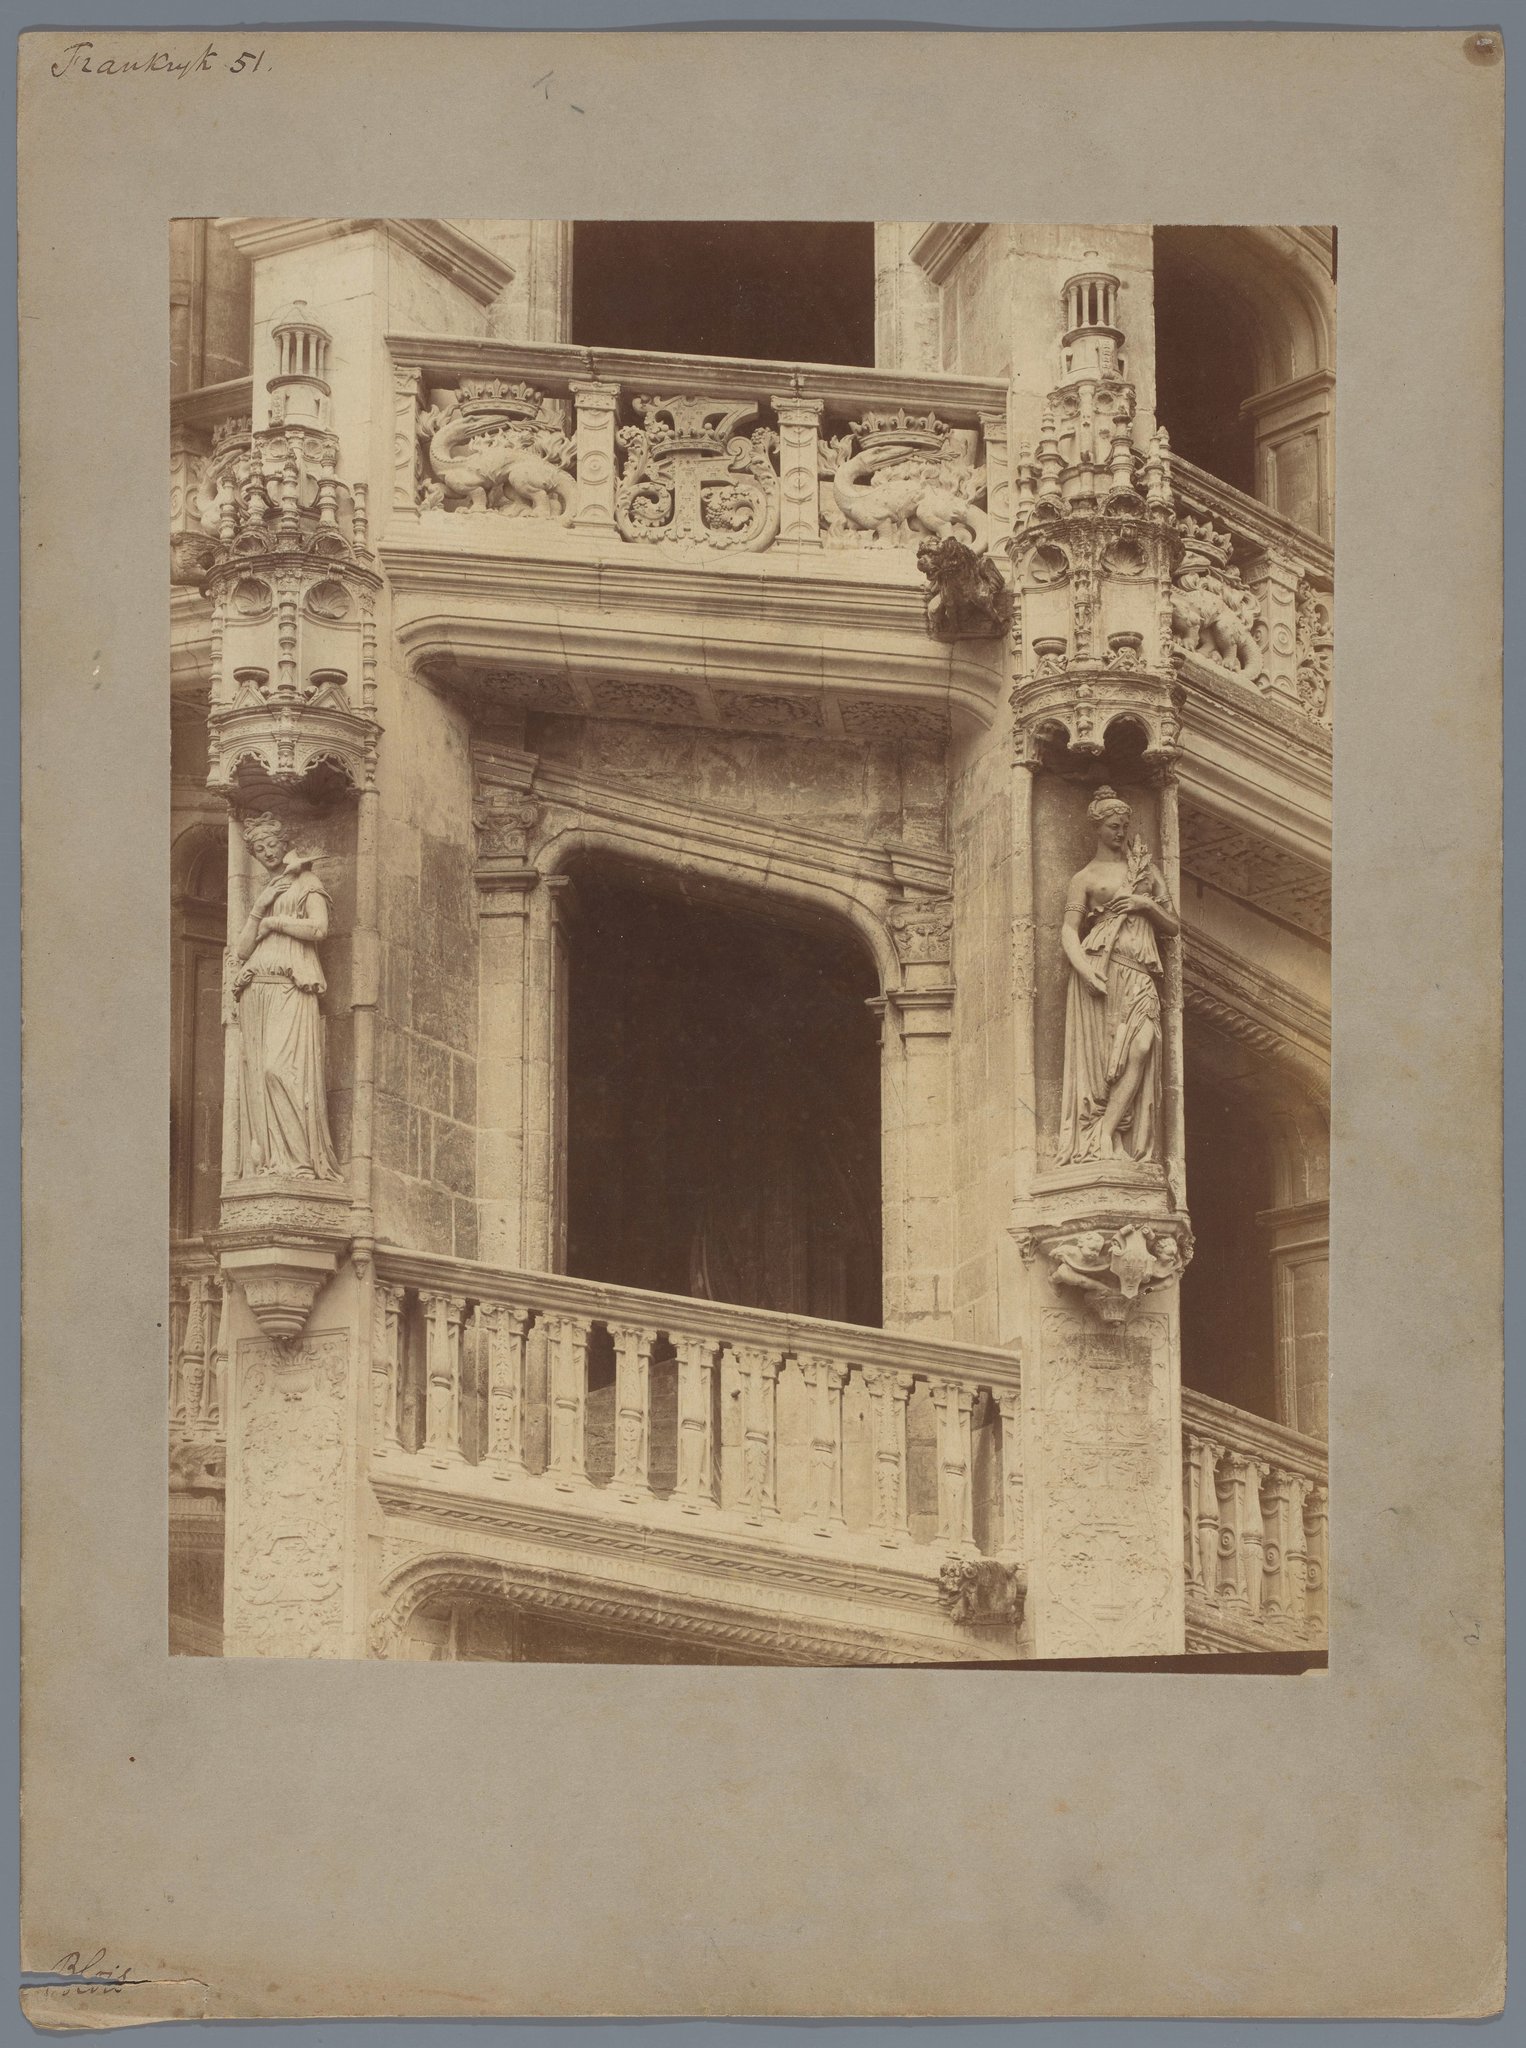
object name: photograph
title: Balkon van het kasteel van Blois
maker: Anonymous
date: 1850-1900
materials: cardboard, photographic support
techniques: albumen print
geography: blois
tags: castle, balcony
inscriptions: annotation: ‘Blois’, annotation: ‘Blois’, collector's mark: ‘RIJK[S NORMA]ALSCHOOL voor T[EEKENONDERWIJZERS] AMSTERD[AM]’, annotation: ‘Frankrijk 51.’